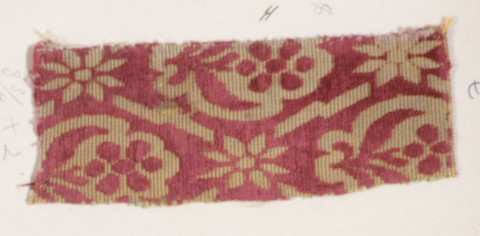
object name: fragment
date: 1601-1700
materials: metal thread, silk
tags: flowers